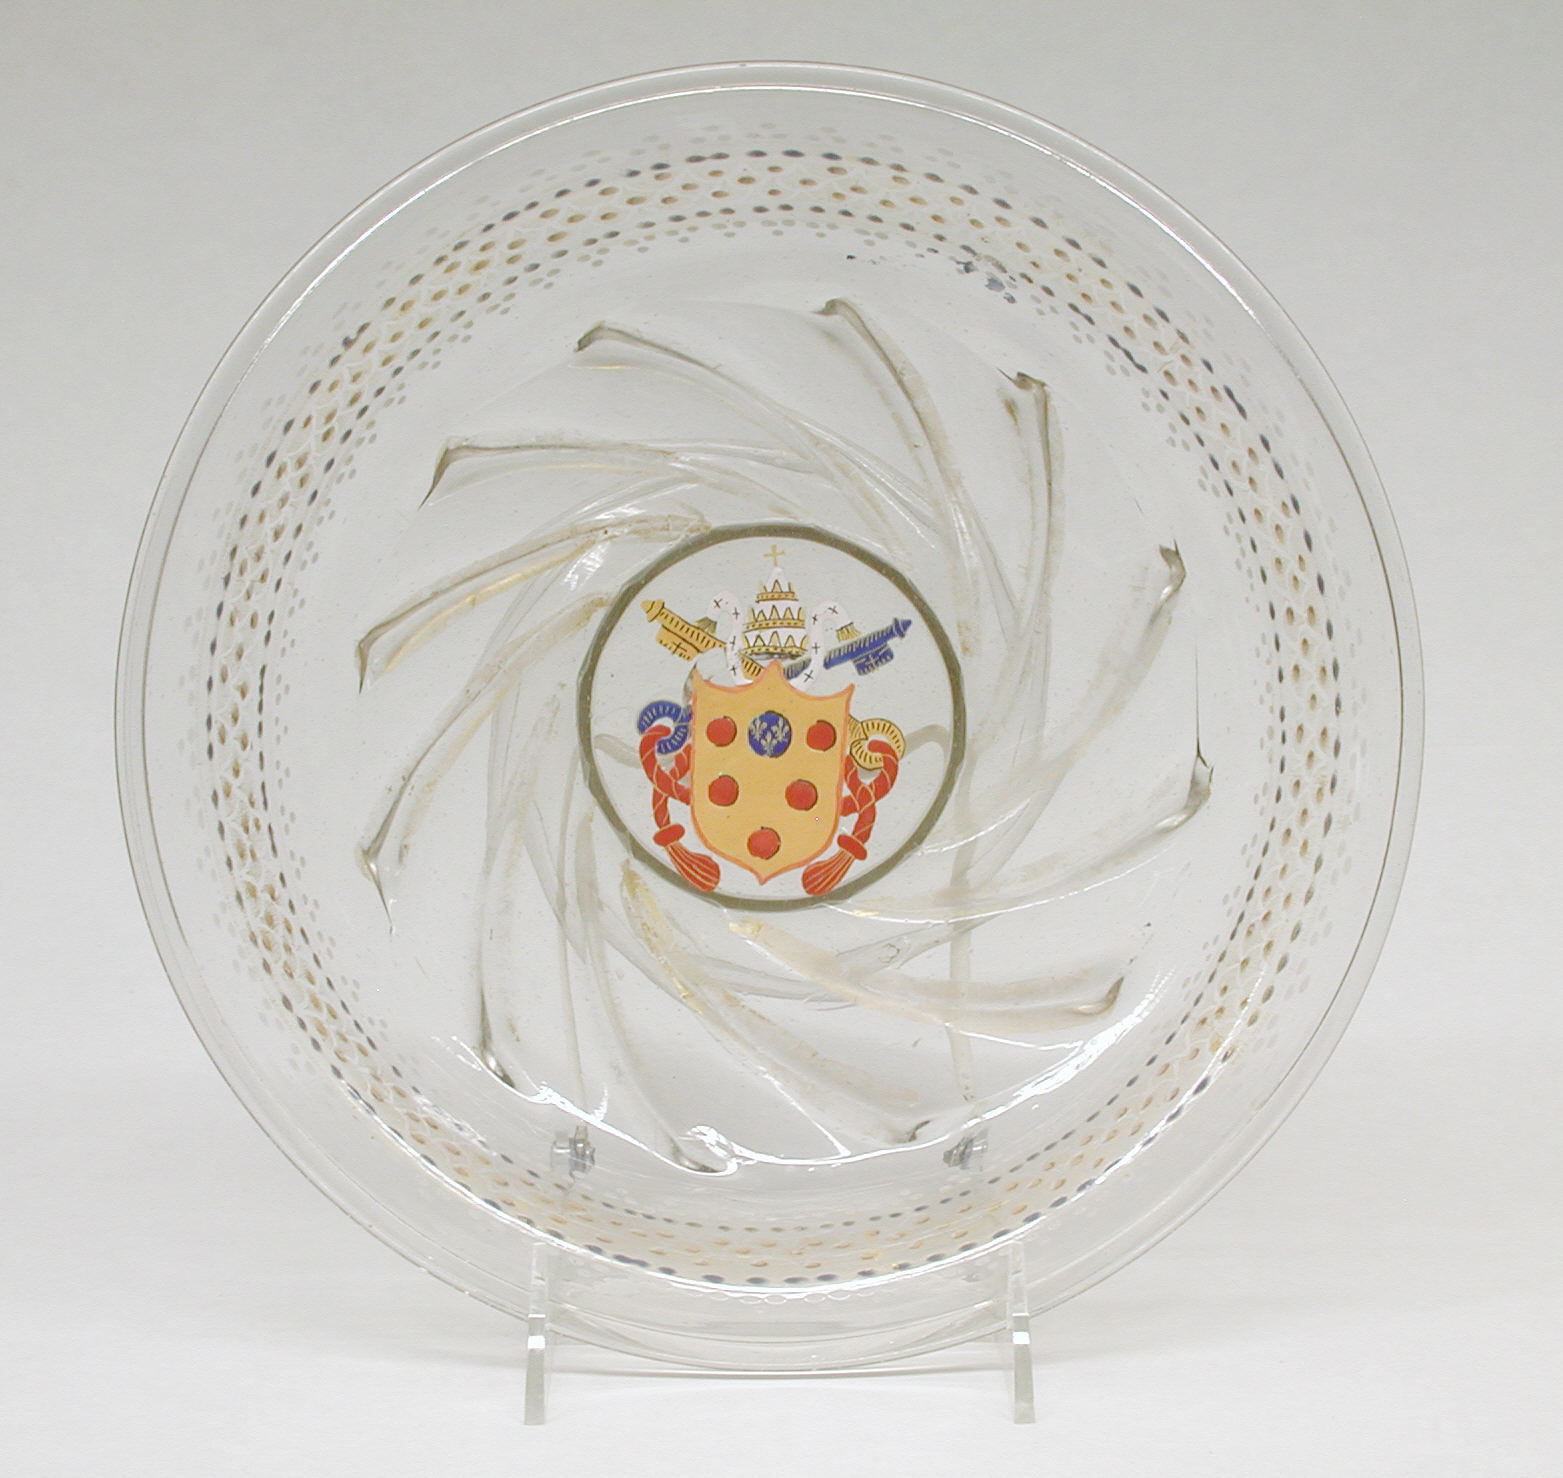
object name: tazza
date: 1501-1533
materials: glass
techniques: enamel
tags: coat of arms